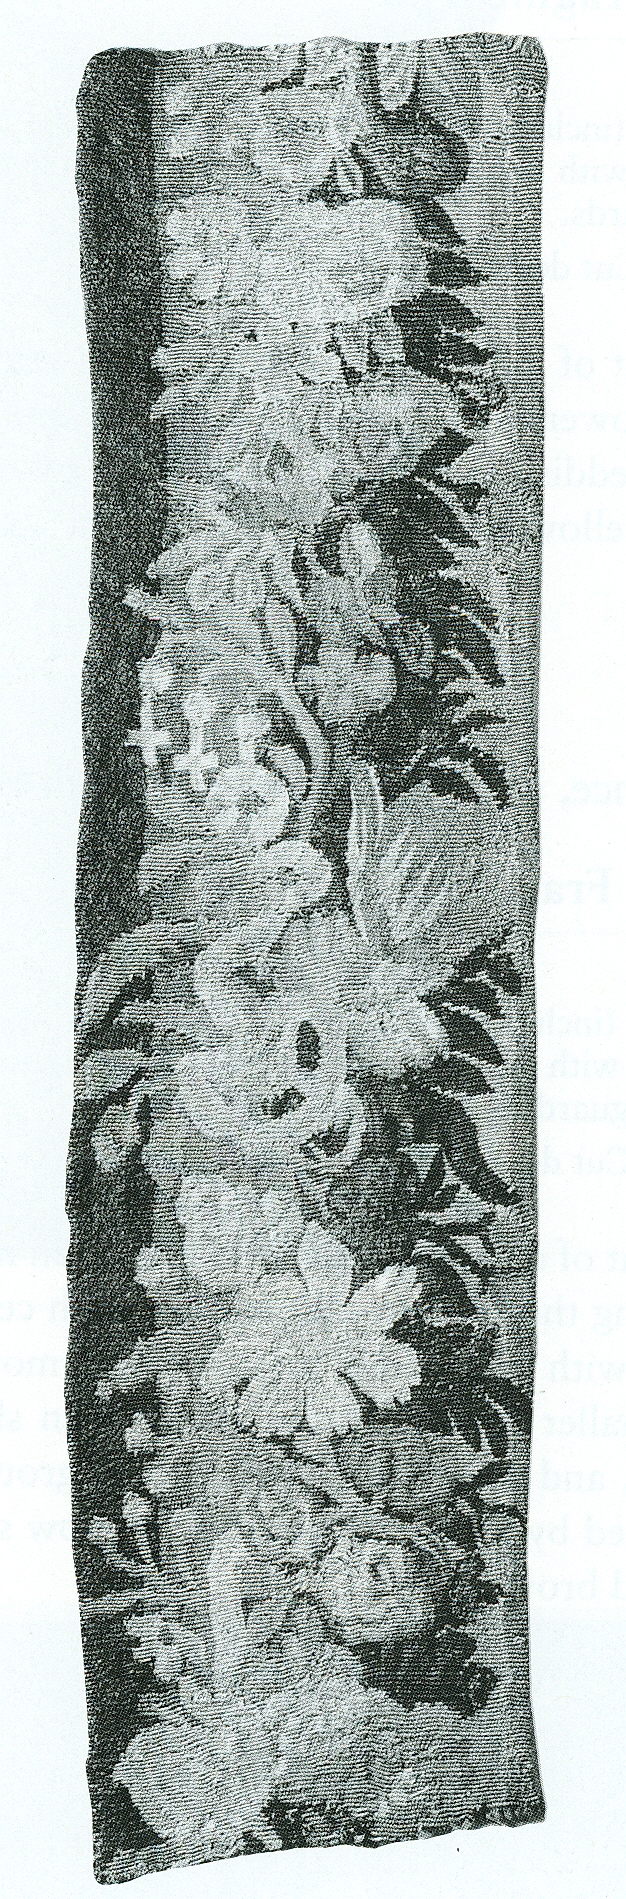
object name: textile border fragment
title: Two border fragments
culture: dutch or french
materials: silk, wool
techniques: highlighting, weave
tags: flowers